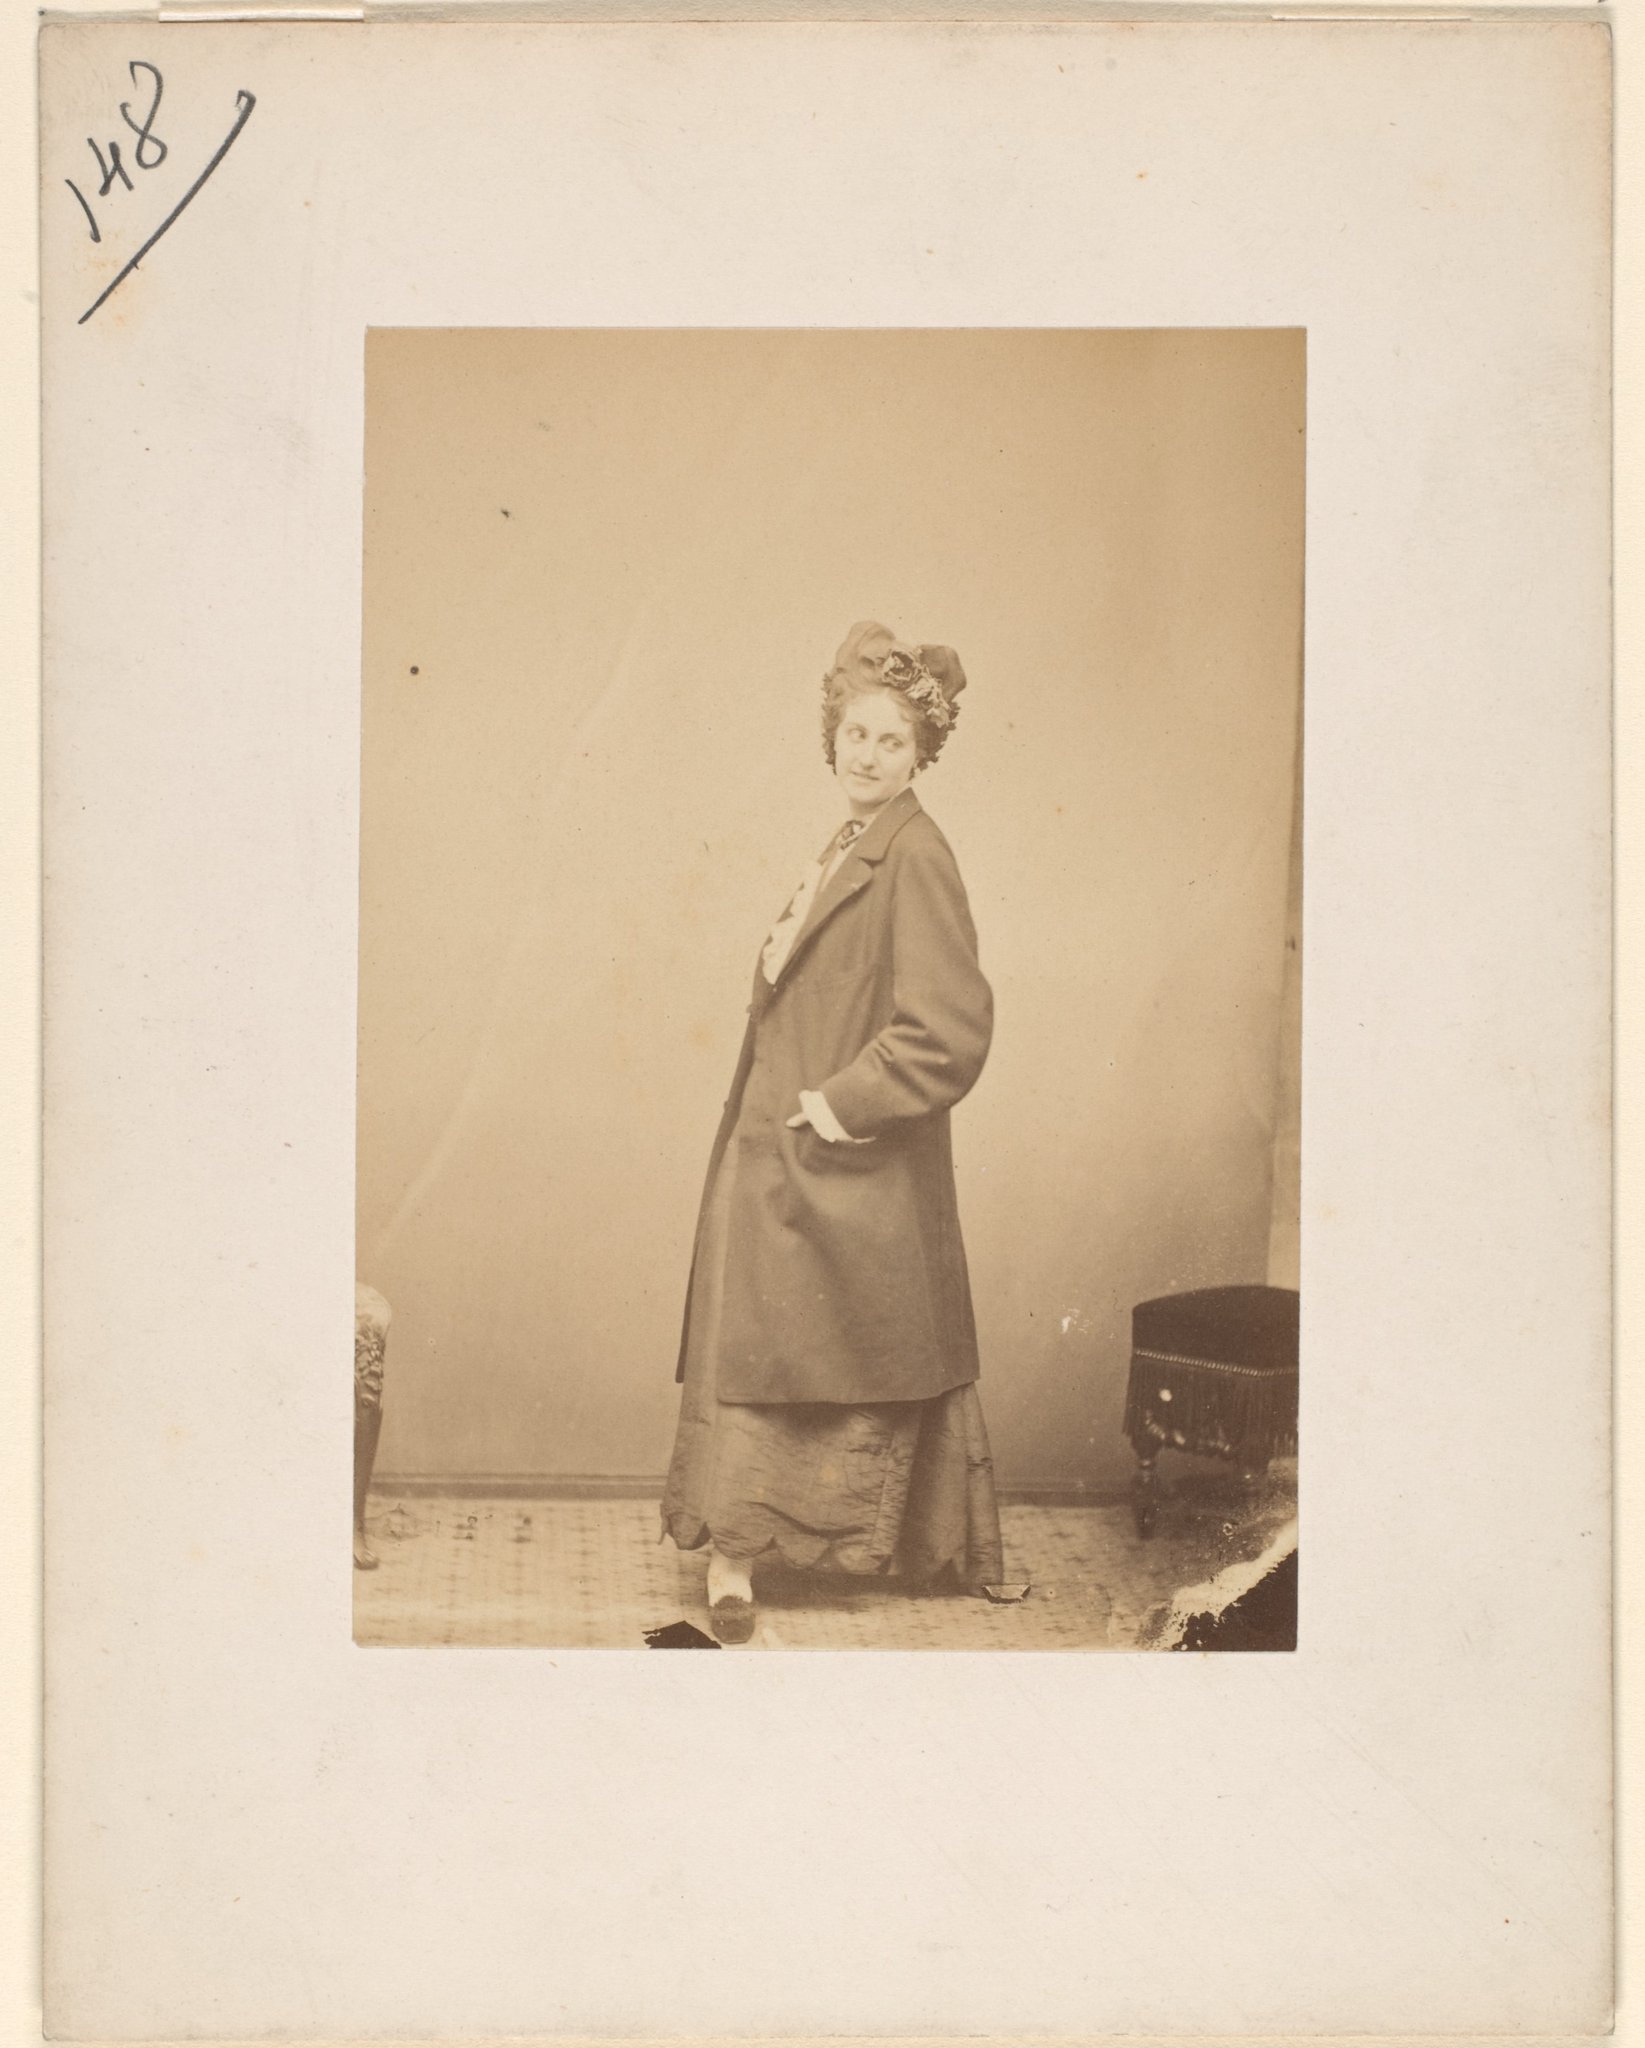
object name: photograph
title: Le pardessus dècoré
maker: pierre-louis pierson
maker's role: artist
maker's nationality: french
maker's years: 1822-1913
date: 1860-1869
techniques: albumen silver print, glass negative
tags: portraits,women